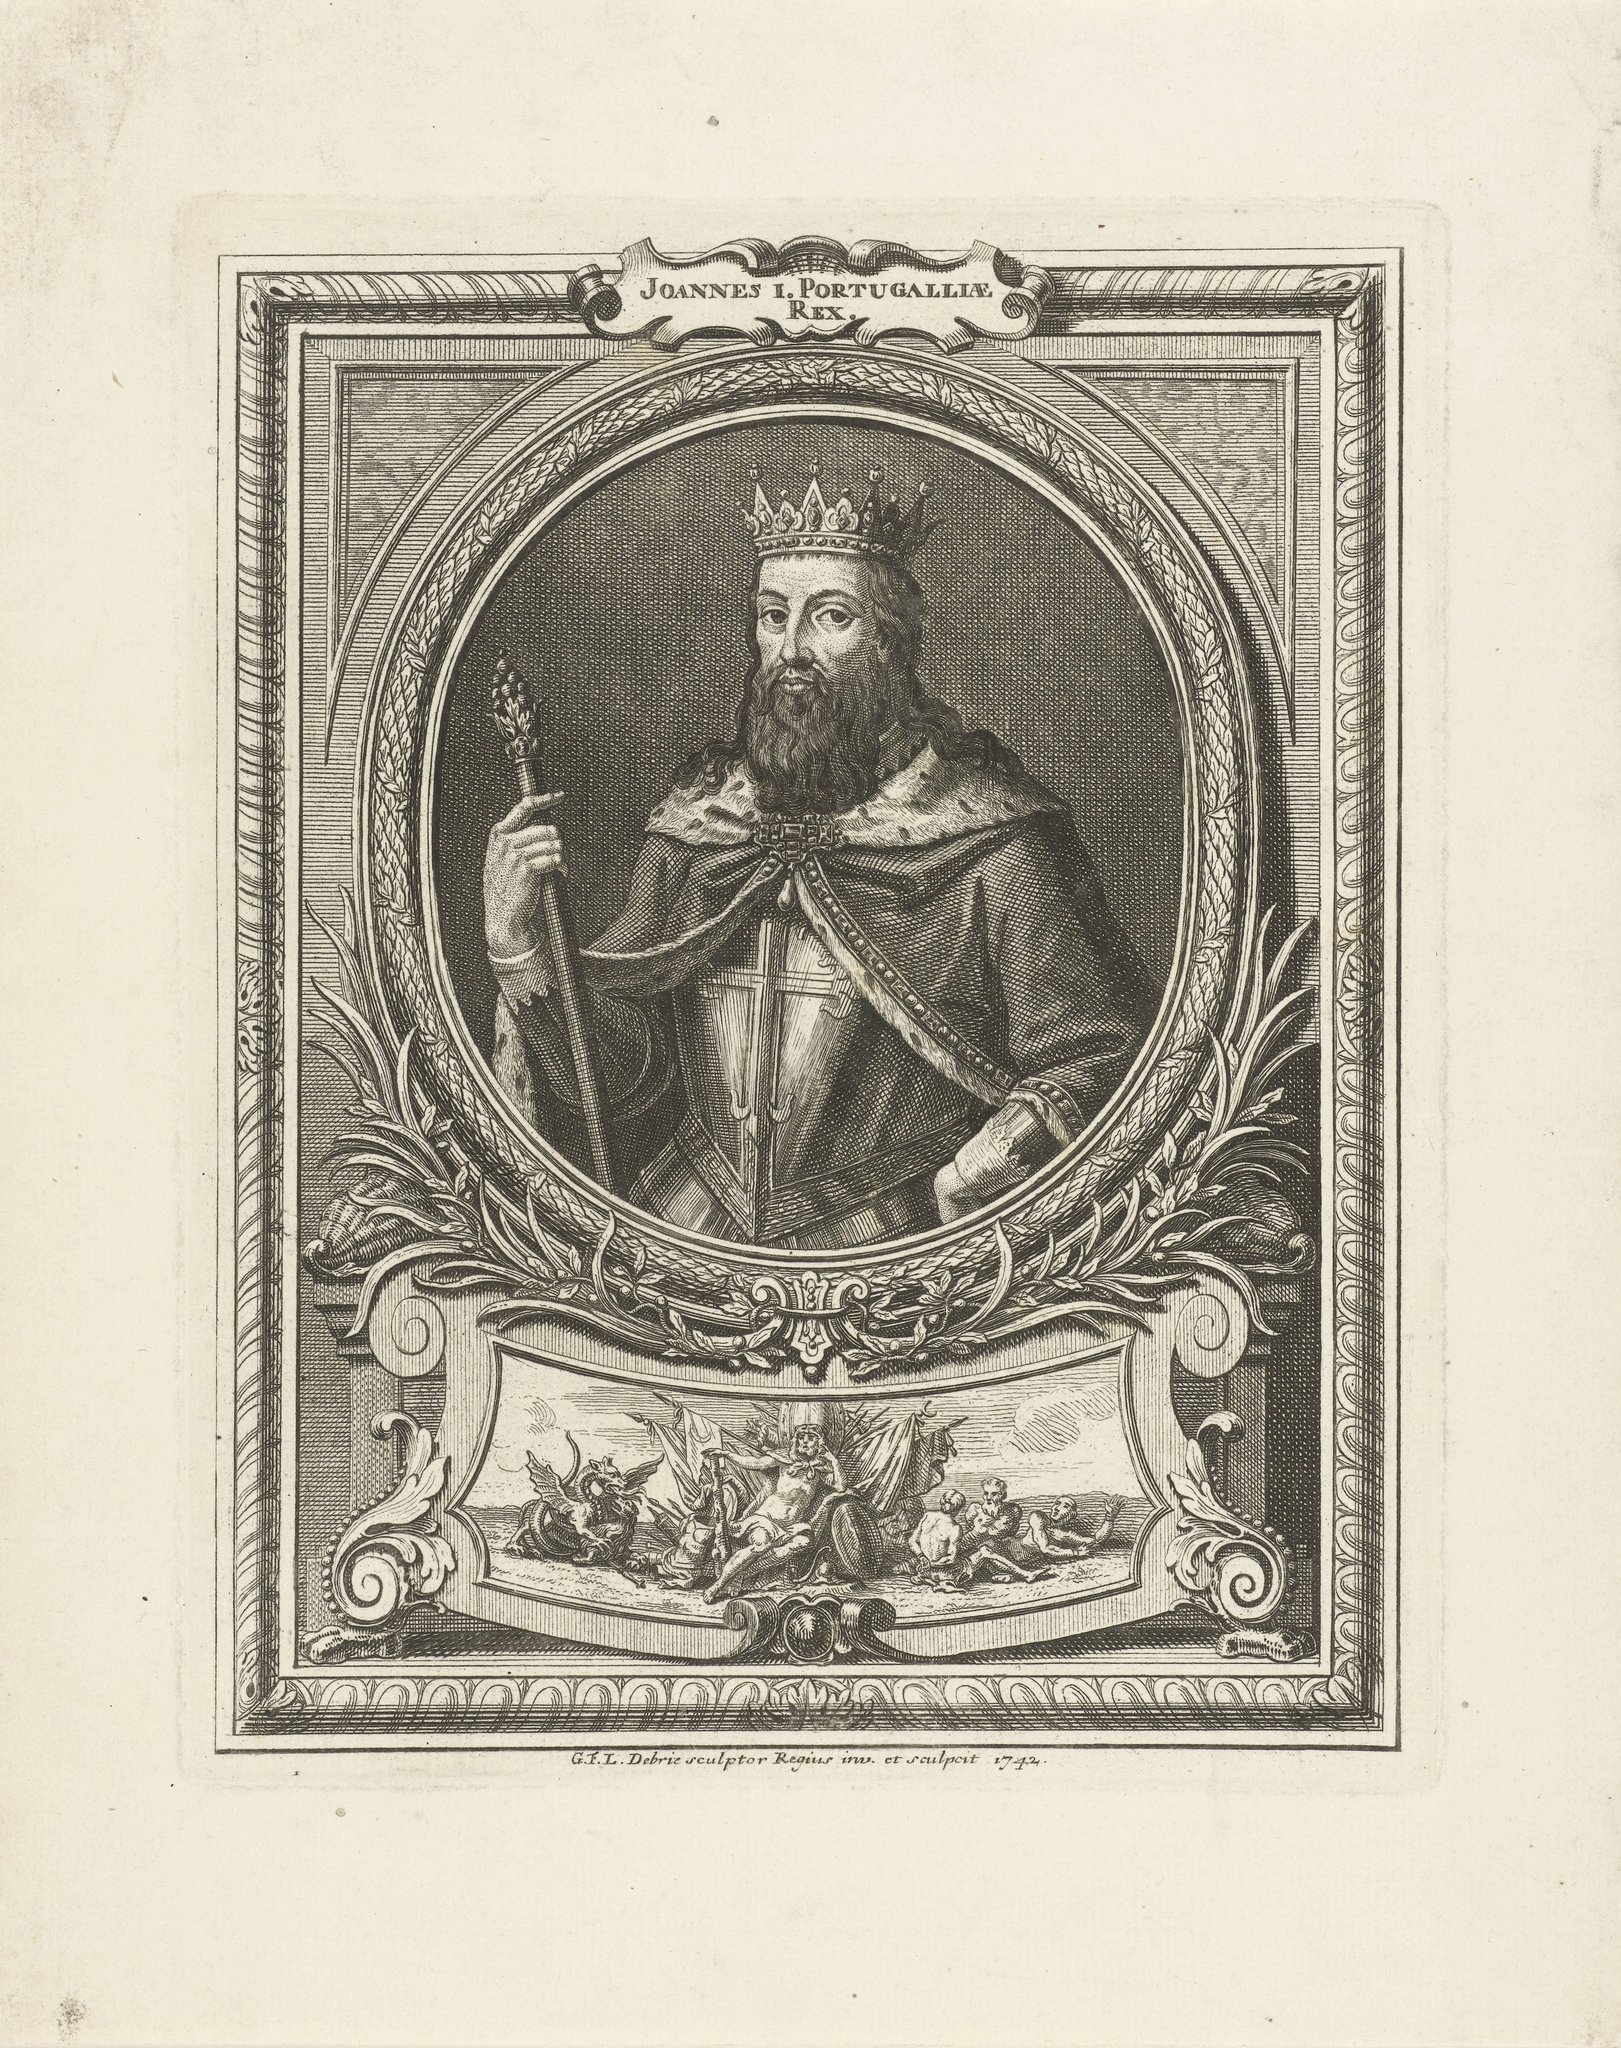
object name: print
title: Portret van Johannes I, koning van Portugal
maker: gabriël françois louis debrie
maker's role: draughtsman, print maker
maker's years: -1754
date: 1742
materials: paper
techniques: etching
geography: portugal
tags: lissabon, johannes i (koning van portugal)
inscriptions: collector's mark: Lugt 2228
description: Portret van Johannes I, koning van Portugal, staand ten halven lijve, gekleed in harnas met daarover een koningsmantel, scepter in zijn hand en kroon op zijn hoofd, in ovale omlijsting met lauwerkrans. Onder cartouche met Hercules zittend bij oorlogstrofeeën, het geheel binnen rechthoekige omlijsting.